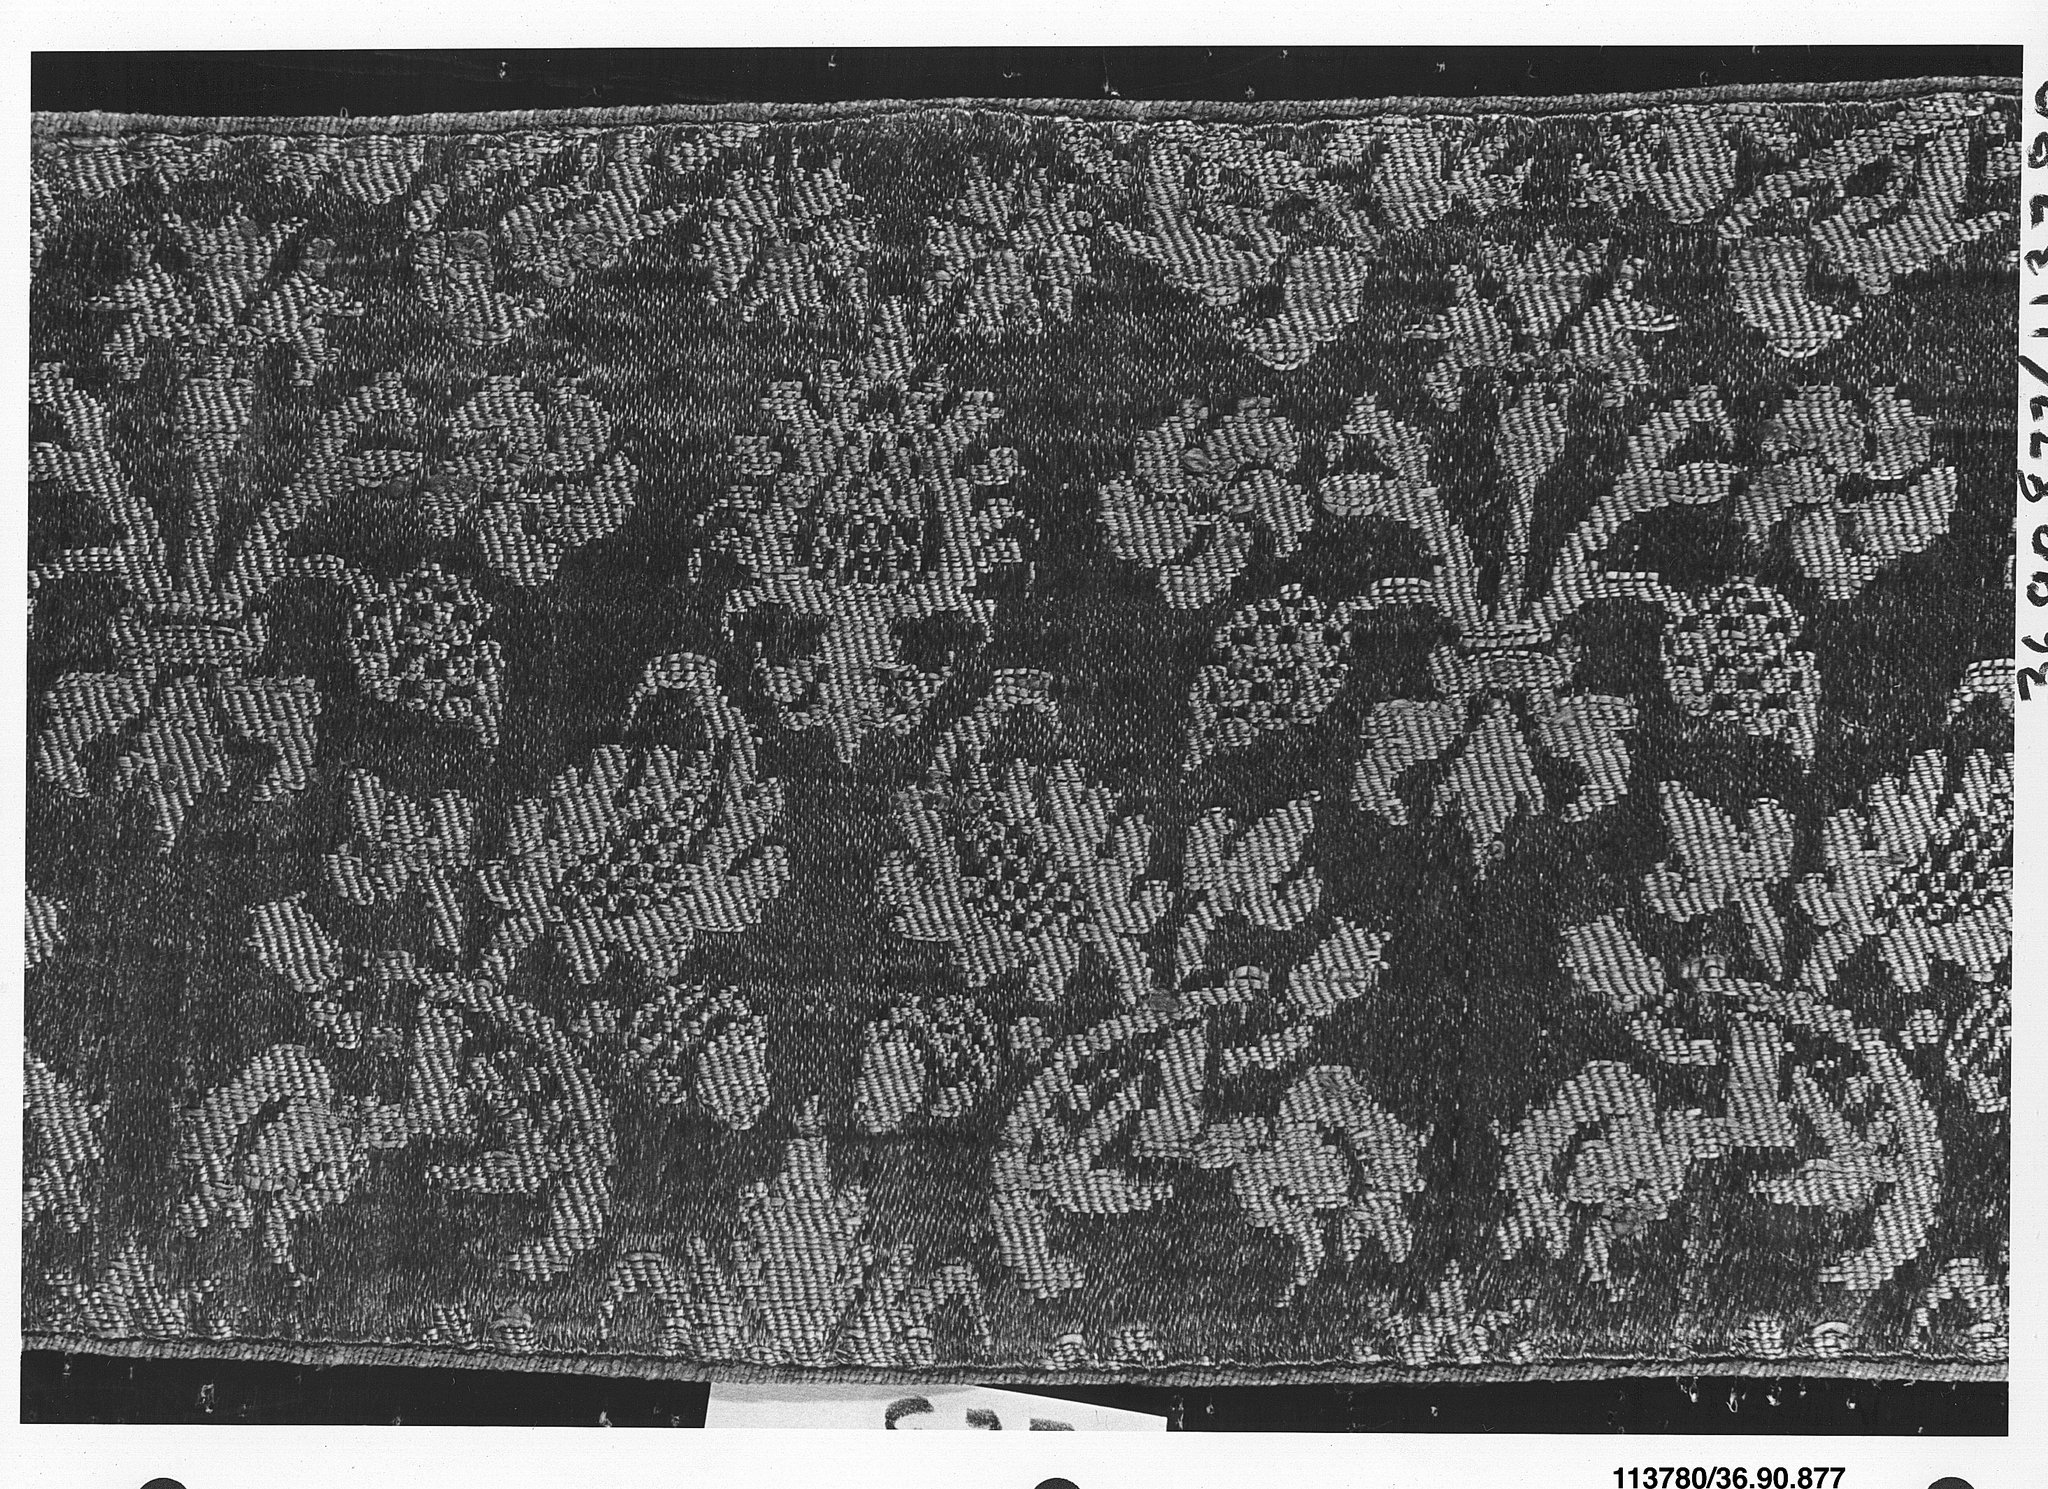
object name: piece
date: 1601-1700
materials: silk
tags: flowers,leaves